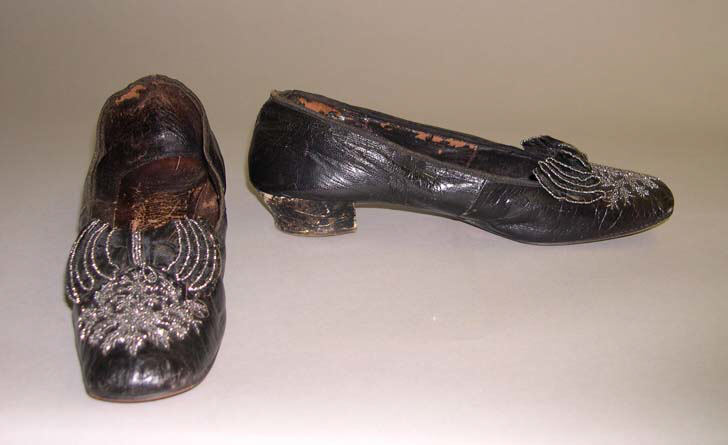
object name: shoe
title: Shoes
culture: british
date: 1867-1900